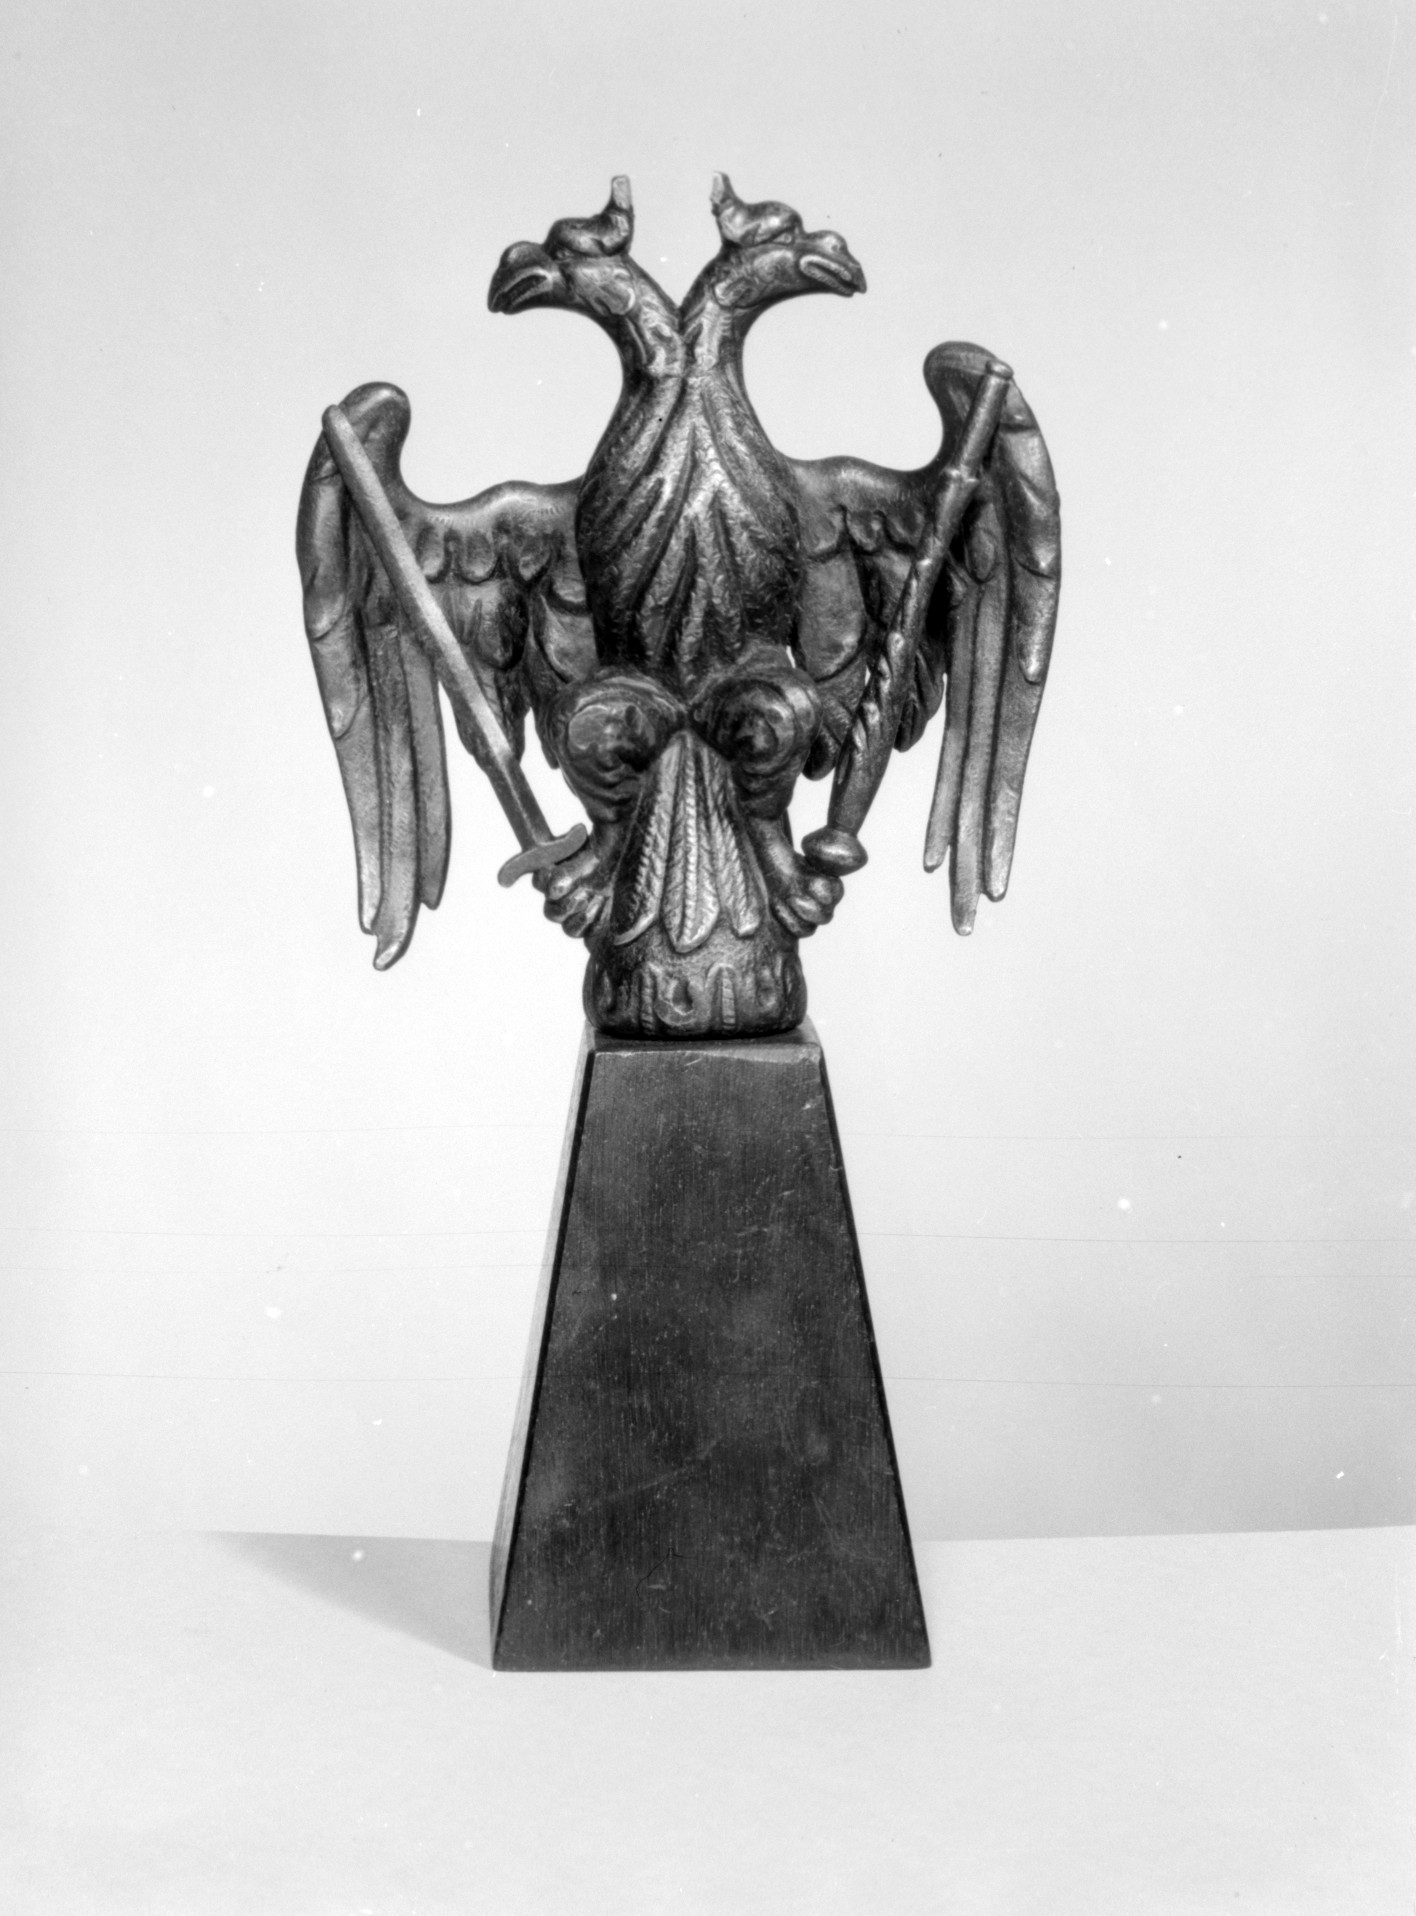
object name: finial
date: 1601-1700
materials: iron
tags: eagles